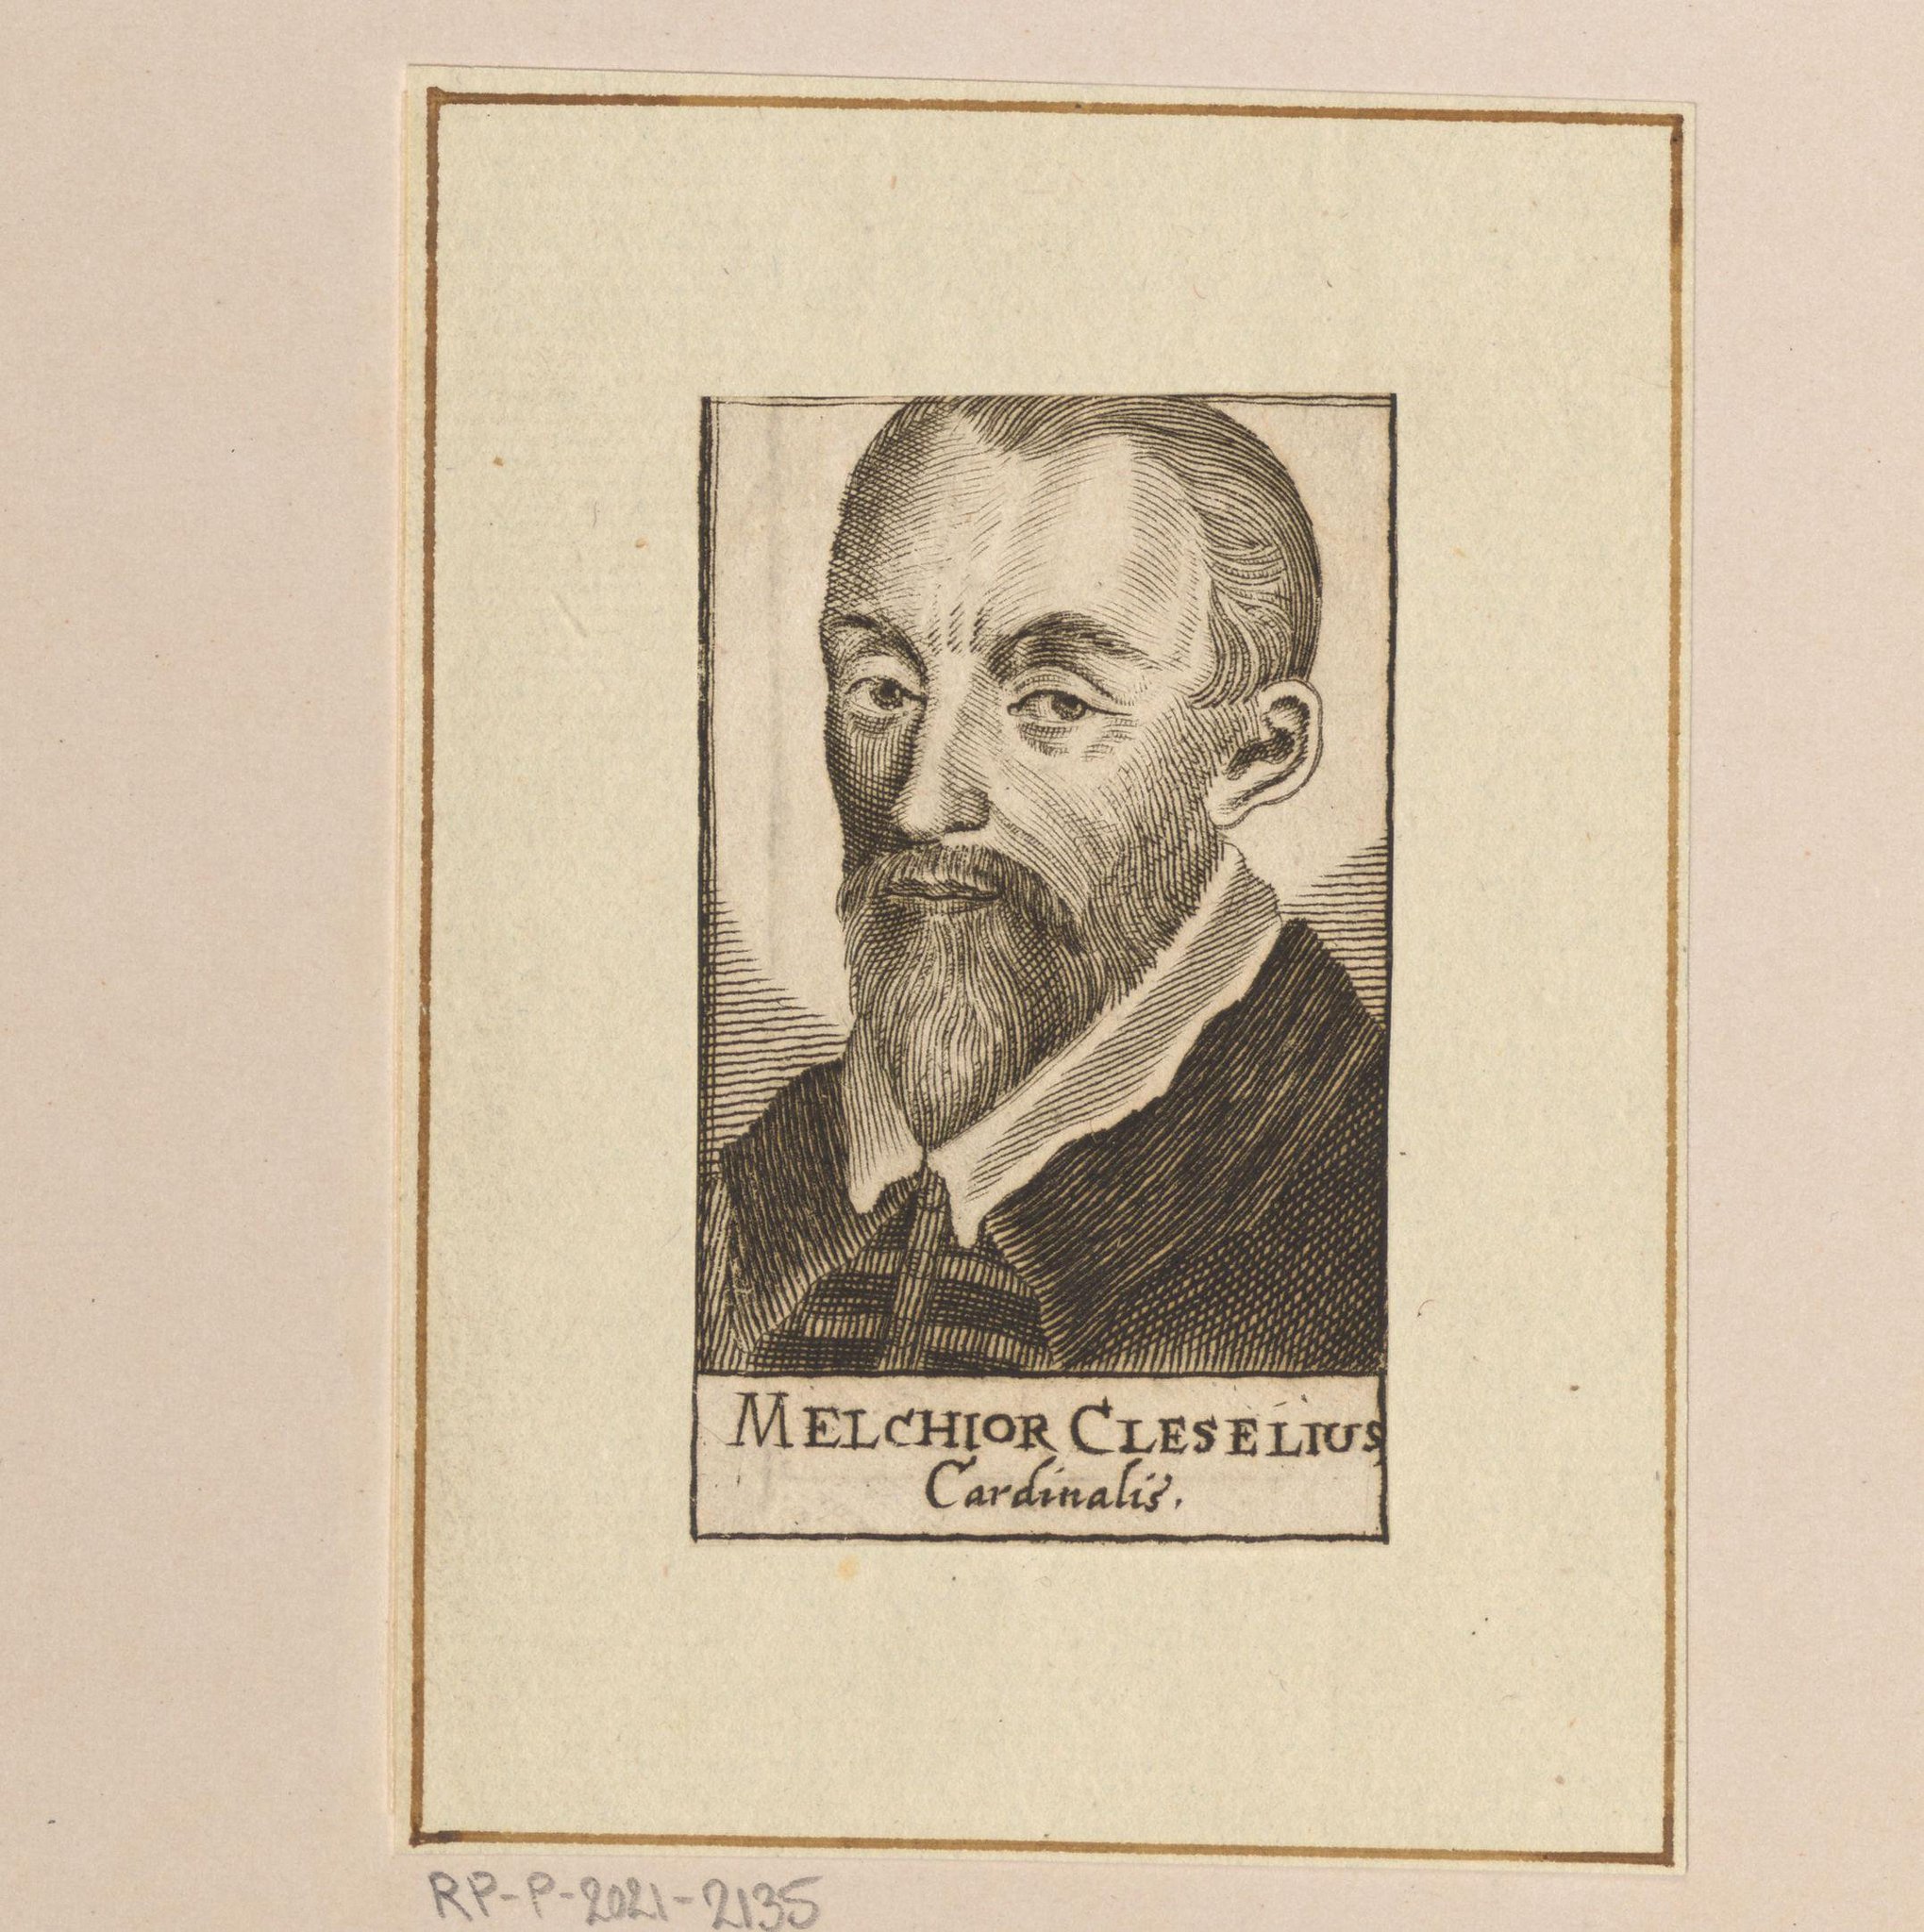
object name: print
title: Portret van Melchior Klesel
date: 1688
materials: paper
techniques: engraving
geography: nuremberg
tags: vienna, historical persons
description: Prent waarschijnlijk uit: Freher, Paul. Theatrum virorum eruditione clarorum. Neurenberg: Johann Hoffmann, 1688.